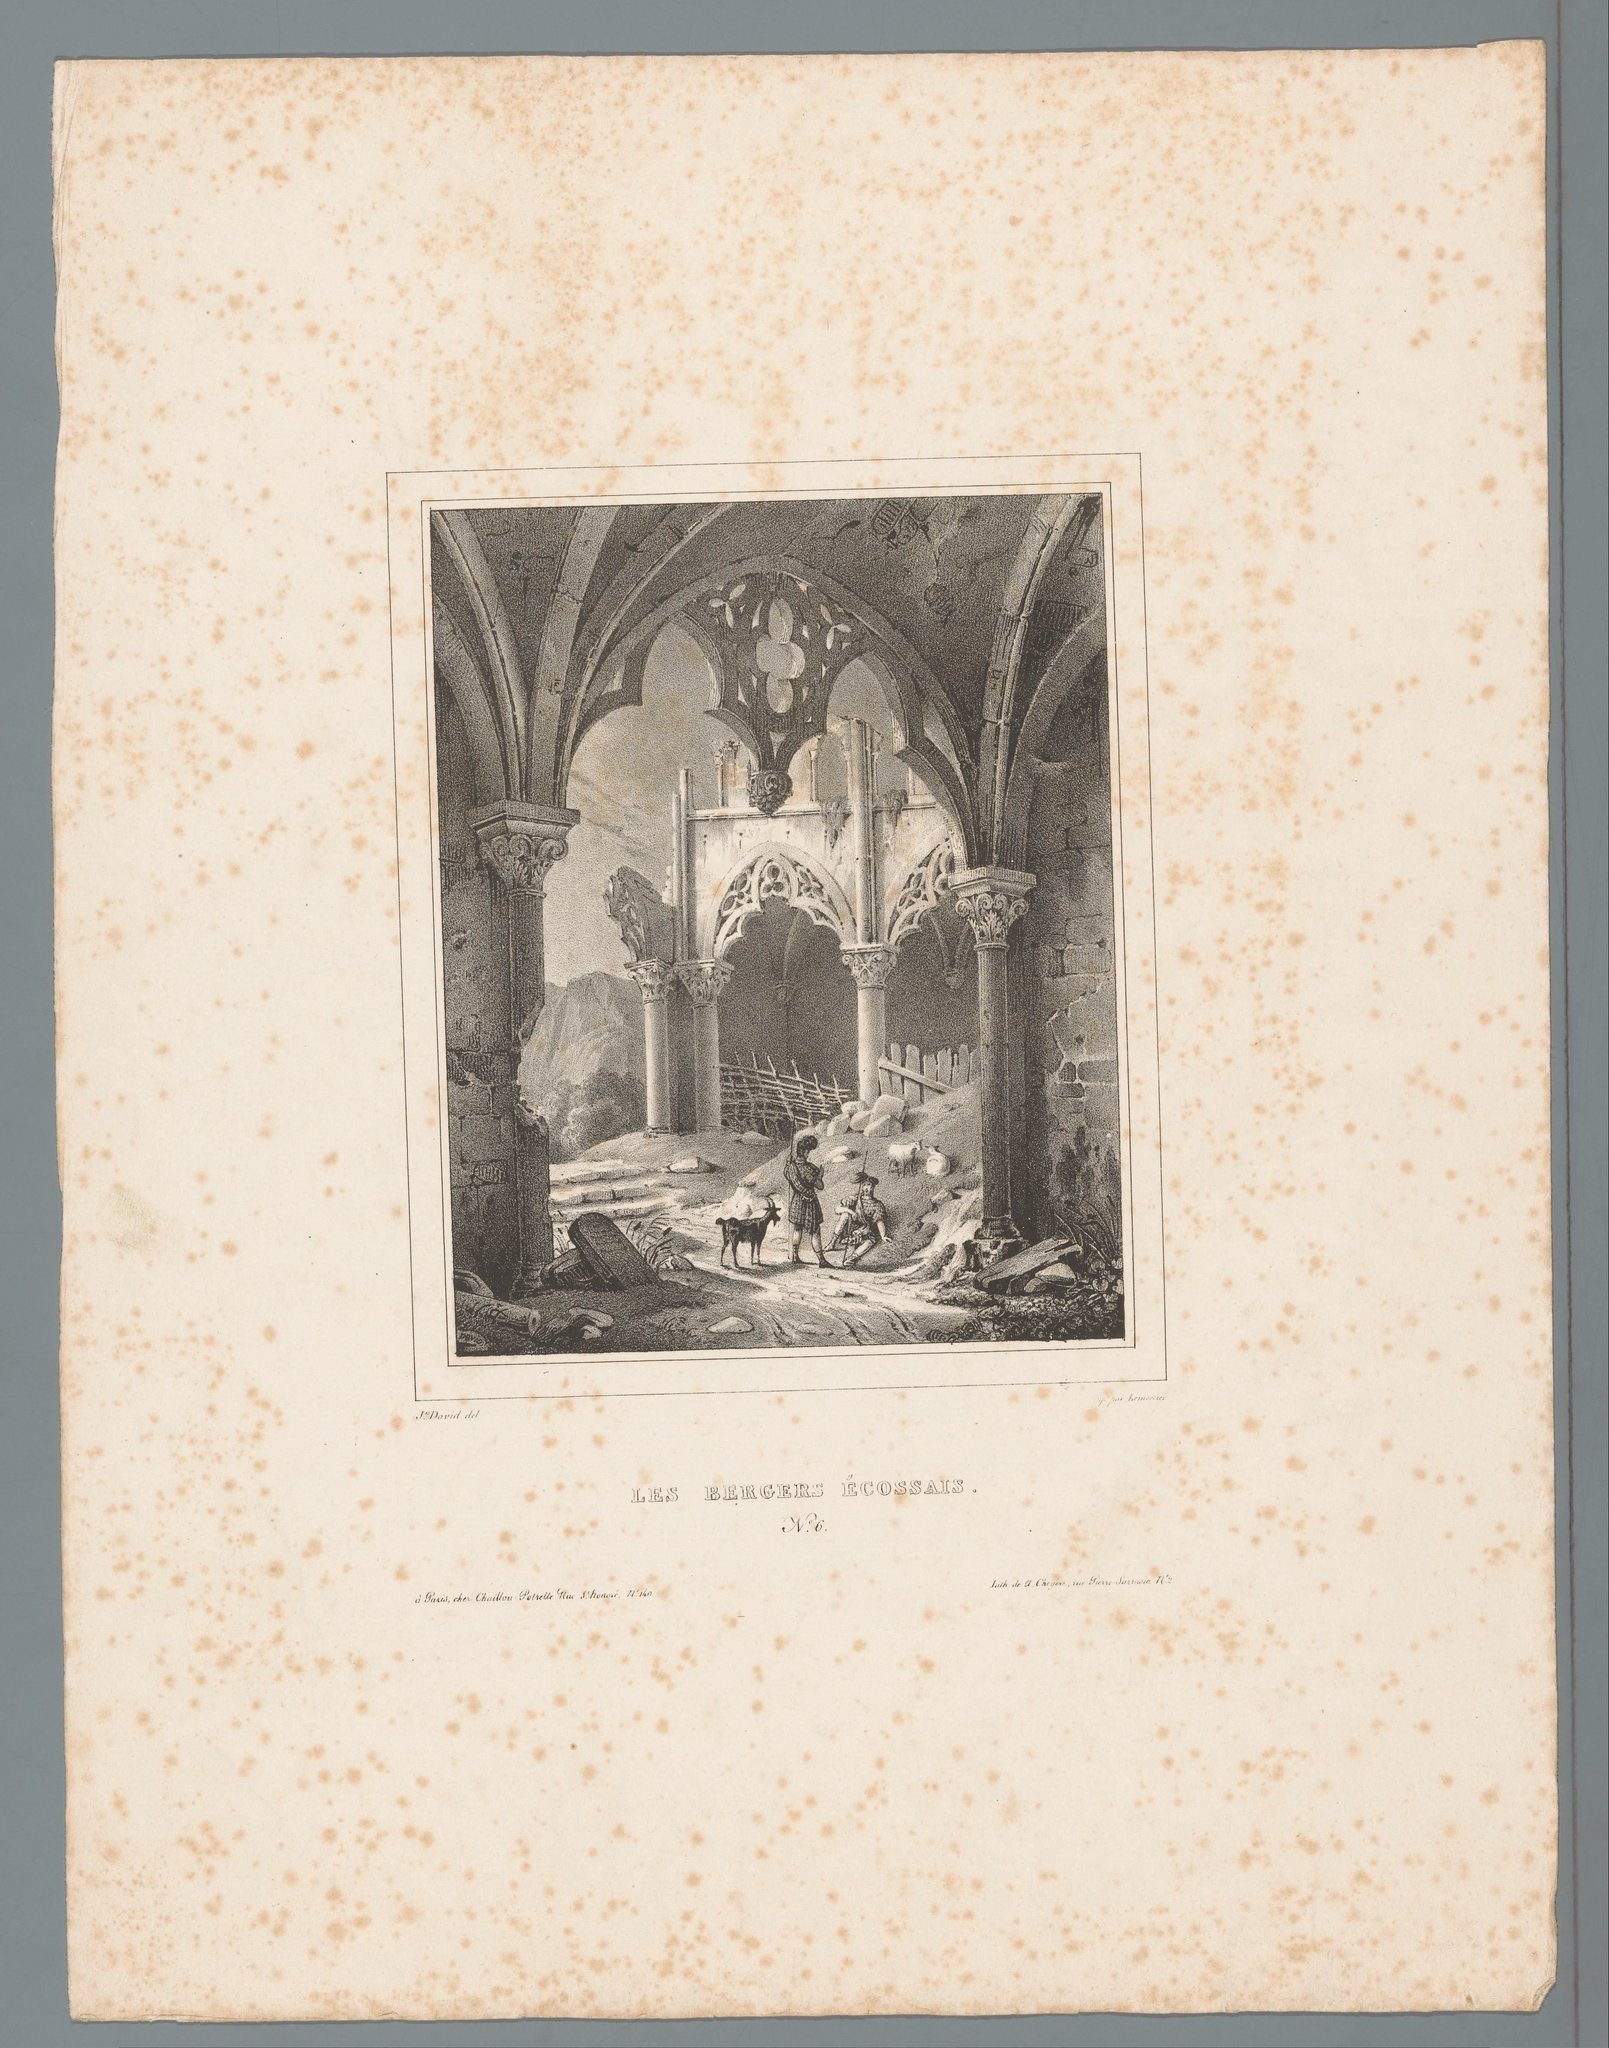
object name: print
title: Zicht op het binnenwerk van gebouwen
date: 1828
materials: paper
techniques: lithograph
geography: paris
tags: herding, herdsman, herdswoman, shepherd, shepherdess, cowherd, etc., ruin of church, monastery, etc.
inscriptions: collector's mark: Lugt 2228a